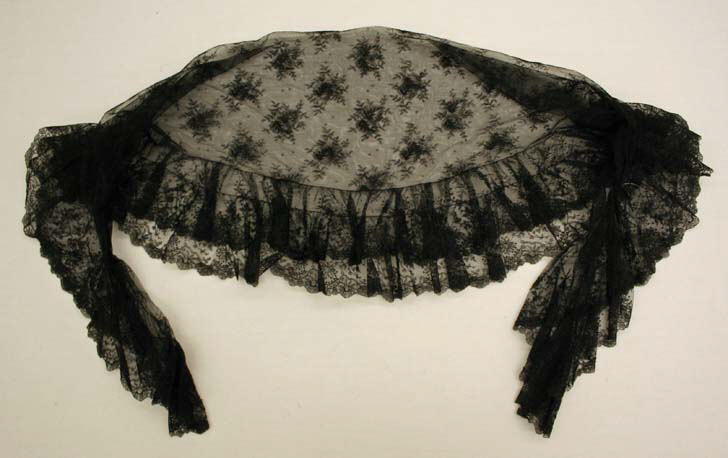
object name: fichu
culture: american or european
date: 1867-1900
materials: cotton, linen